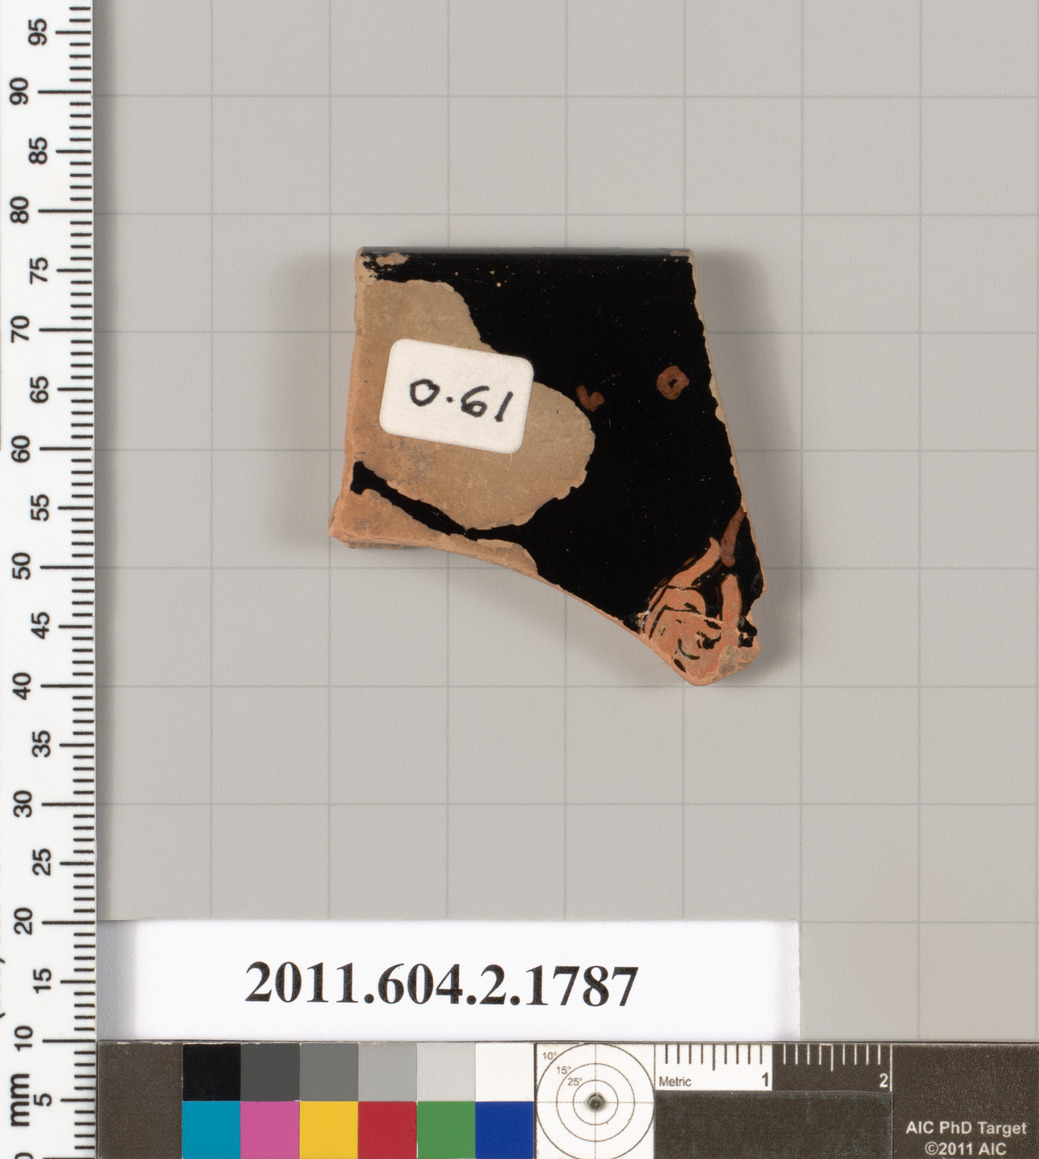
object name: skyphos fragment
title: Terracotta rim fragment of a skyphos (deep drinking cup)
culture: greek, attic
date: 480-470 BCE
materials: terracotta